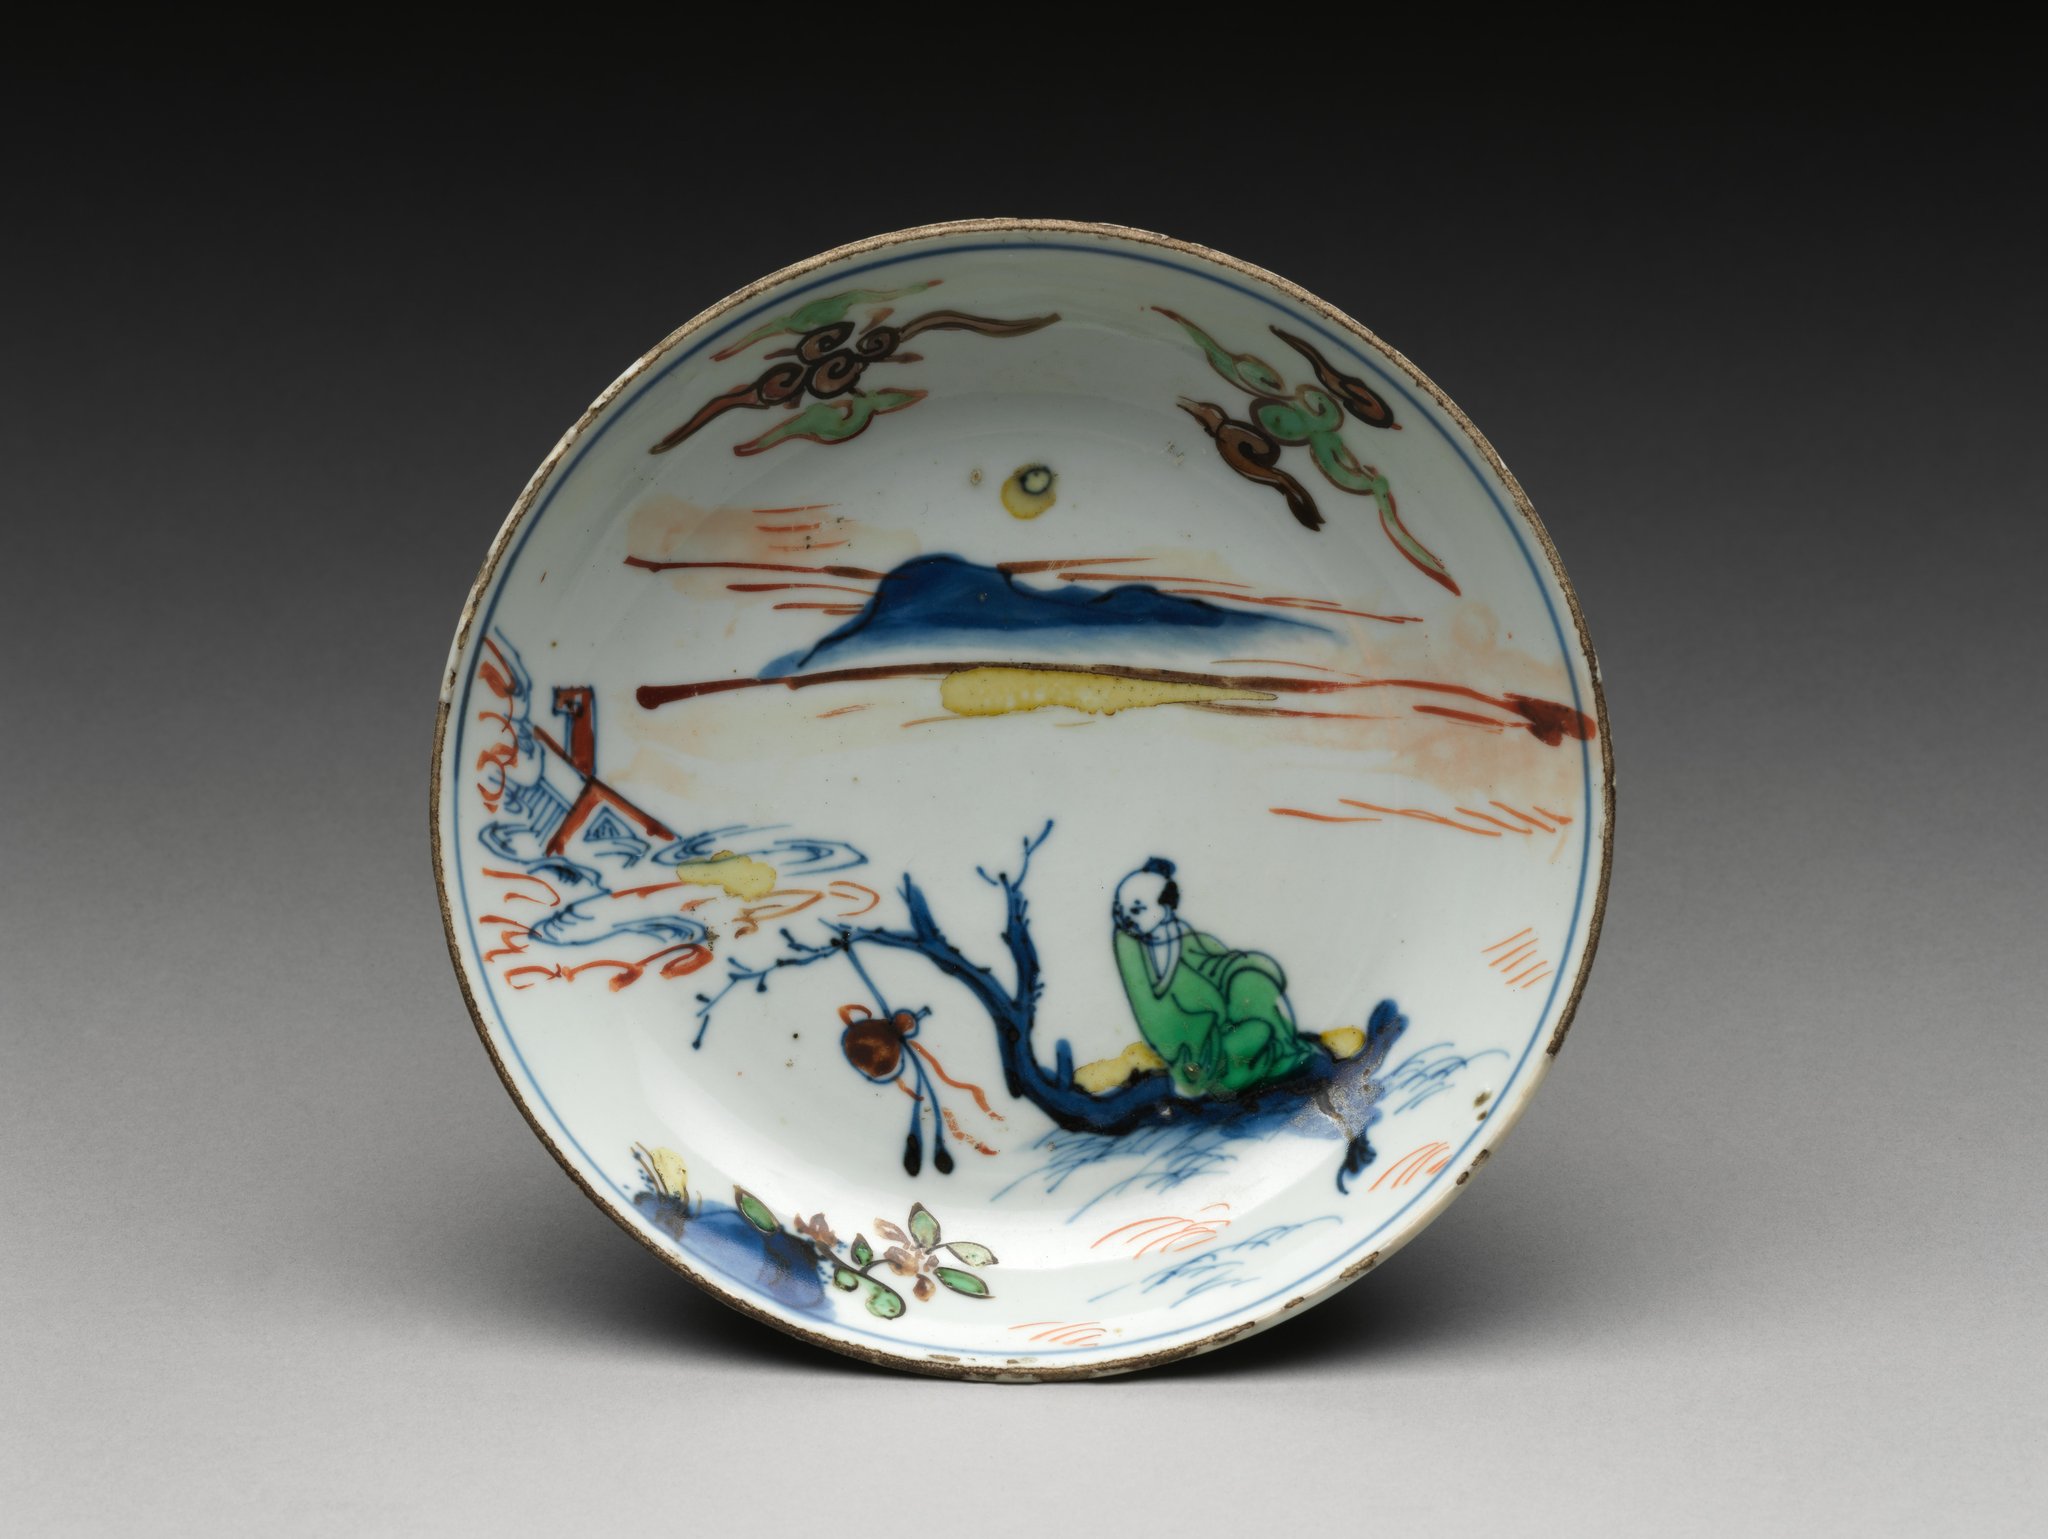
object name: dish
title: Dish with an immortal on raft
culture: chinese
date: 1621-1627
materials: enamel, porcelain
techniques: overglaze, painting, polychrome, underglaze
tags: men,trees